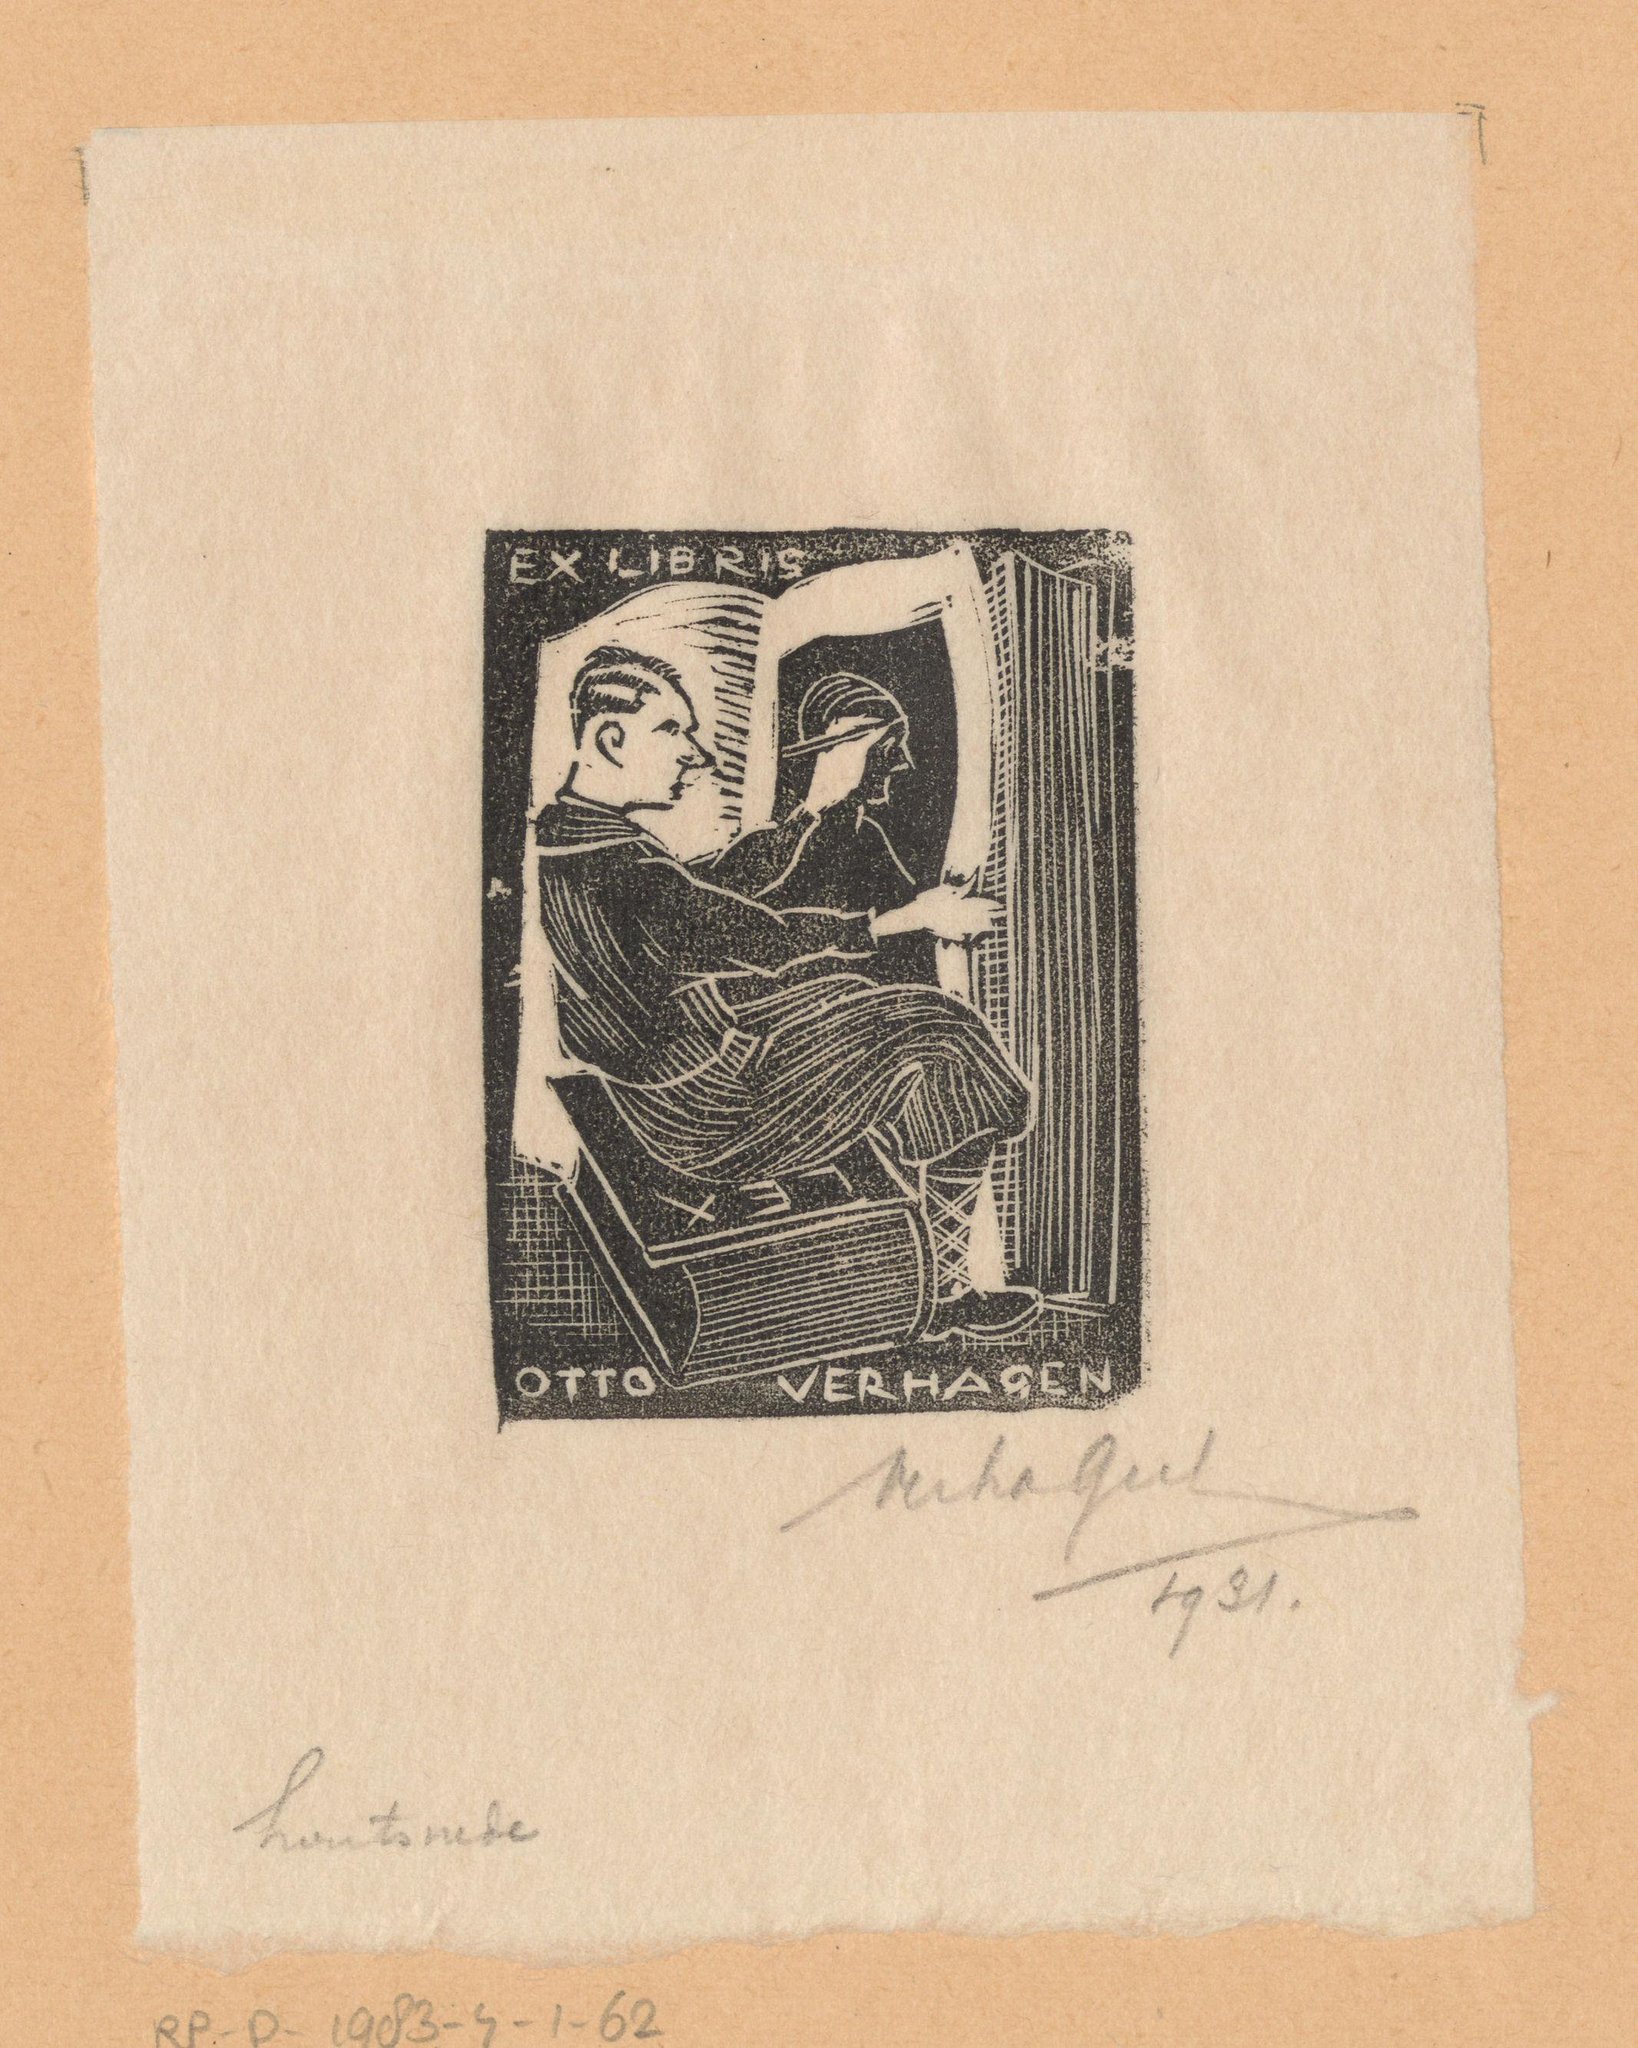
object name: bookplate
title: Ex libris van Otto Verhagen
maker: otto verhagen (i)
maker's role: draughtsman, print maker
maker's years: 1885-1951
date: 1931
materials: paper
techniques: woodcut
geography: netherlands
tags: the hague, print maker, draughtsman, otto verhagen (i), sitting figure, draughtsman at work, book, law and jurisprudence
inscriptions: signature and date: ‘Verhagen/ 1931/ houtsnede’, inscription: ‘Houtsnede (kopspalmhout) - jaar (...) en Stols, Maastricht.’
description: De voorstelling is een karikatuur: het beroep is gesymboliseerd door het wetboek (Lex), de liefhebberij voor het boek is tevens door het boek verbeeld. Ex libris is opgenomen in J. Schwencke, "Bibliographie over het Nederlandsche ex libris", Maastricht: 1933.